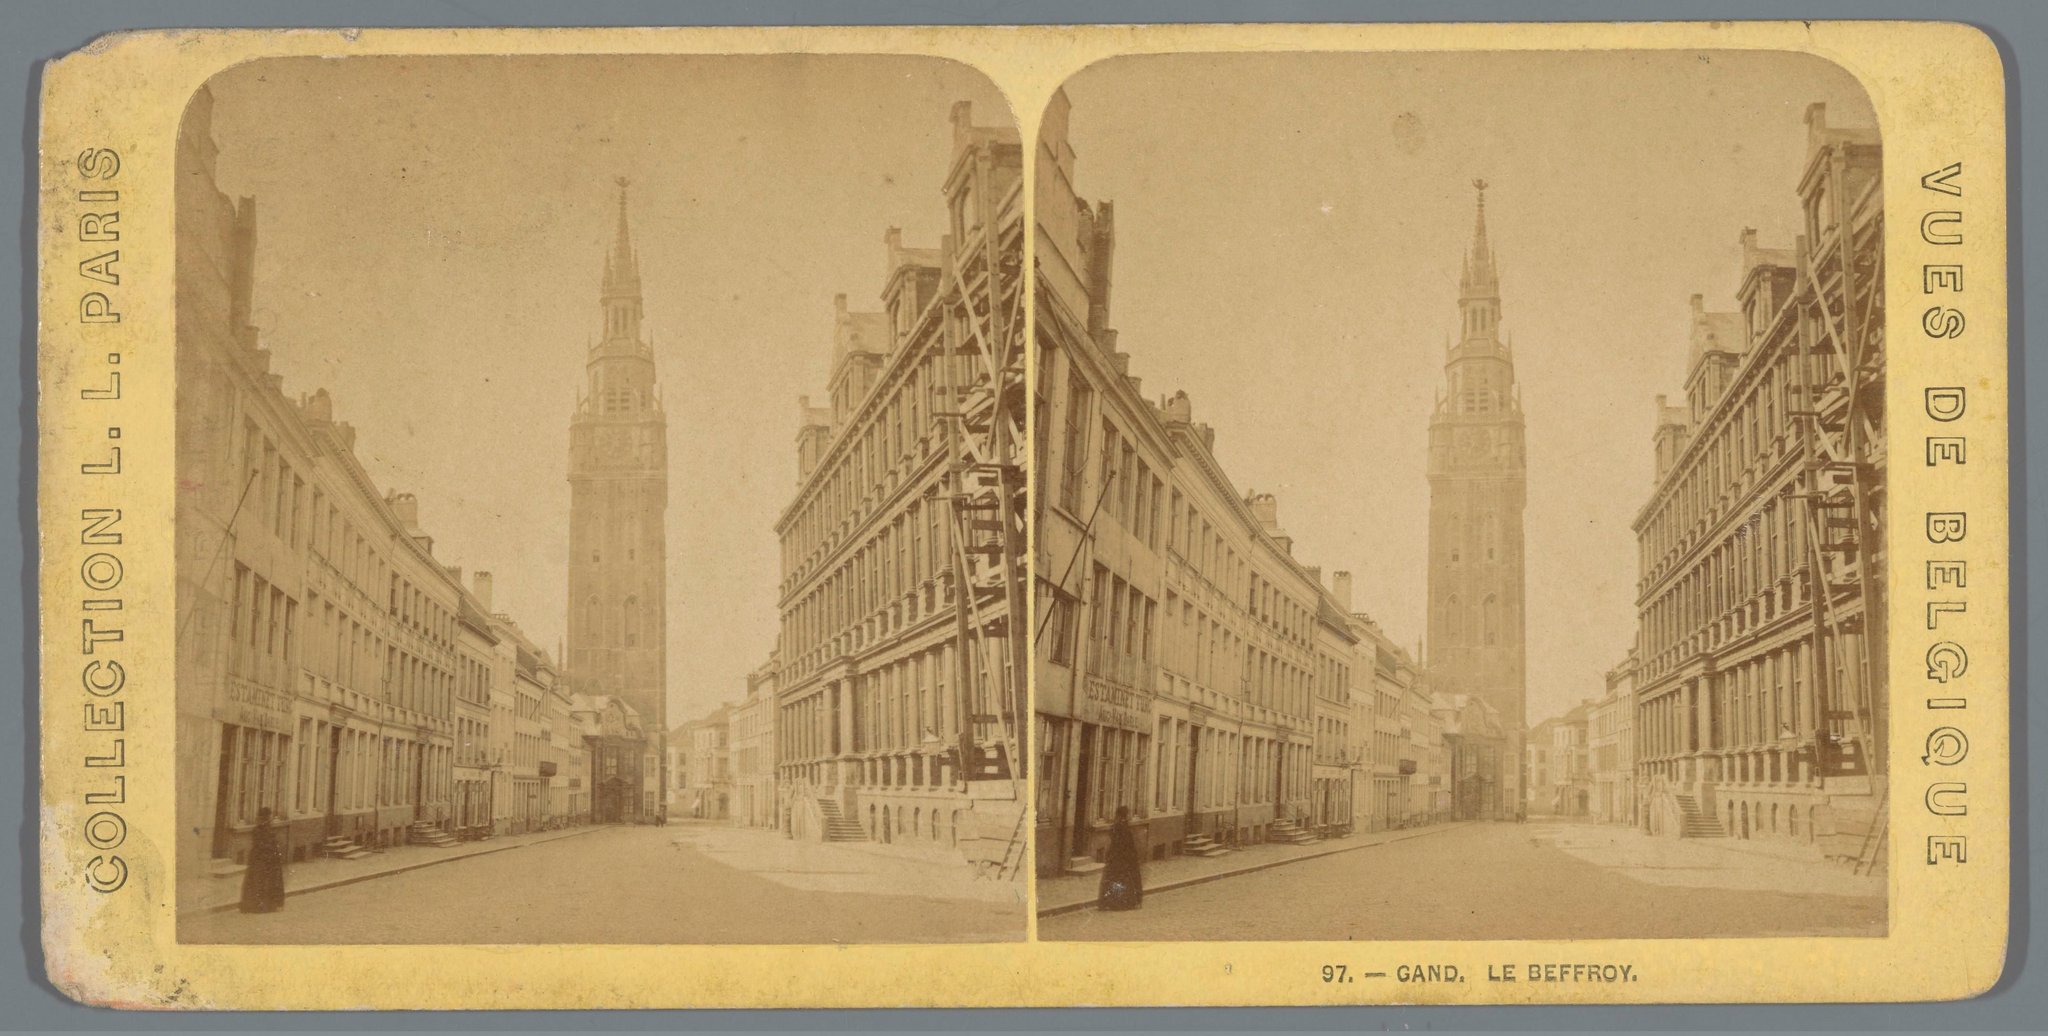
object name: stereograph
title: Vues de Belgique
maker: Anonymous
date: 1873-1890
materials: cardboard, paper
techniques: albumen print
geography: paris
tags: urban housing, tower, clock tower ~ monumental adornment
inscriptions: number: ‘97.’